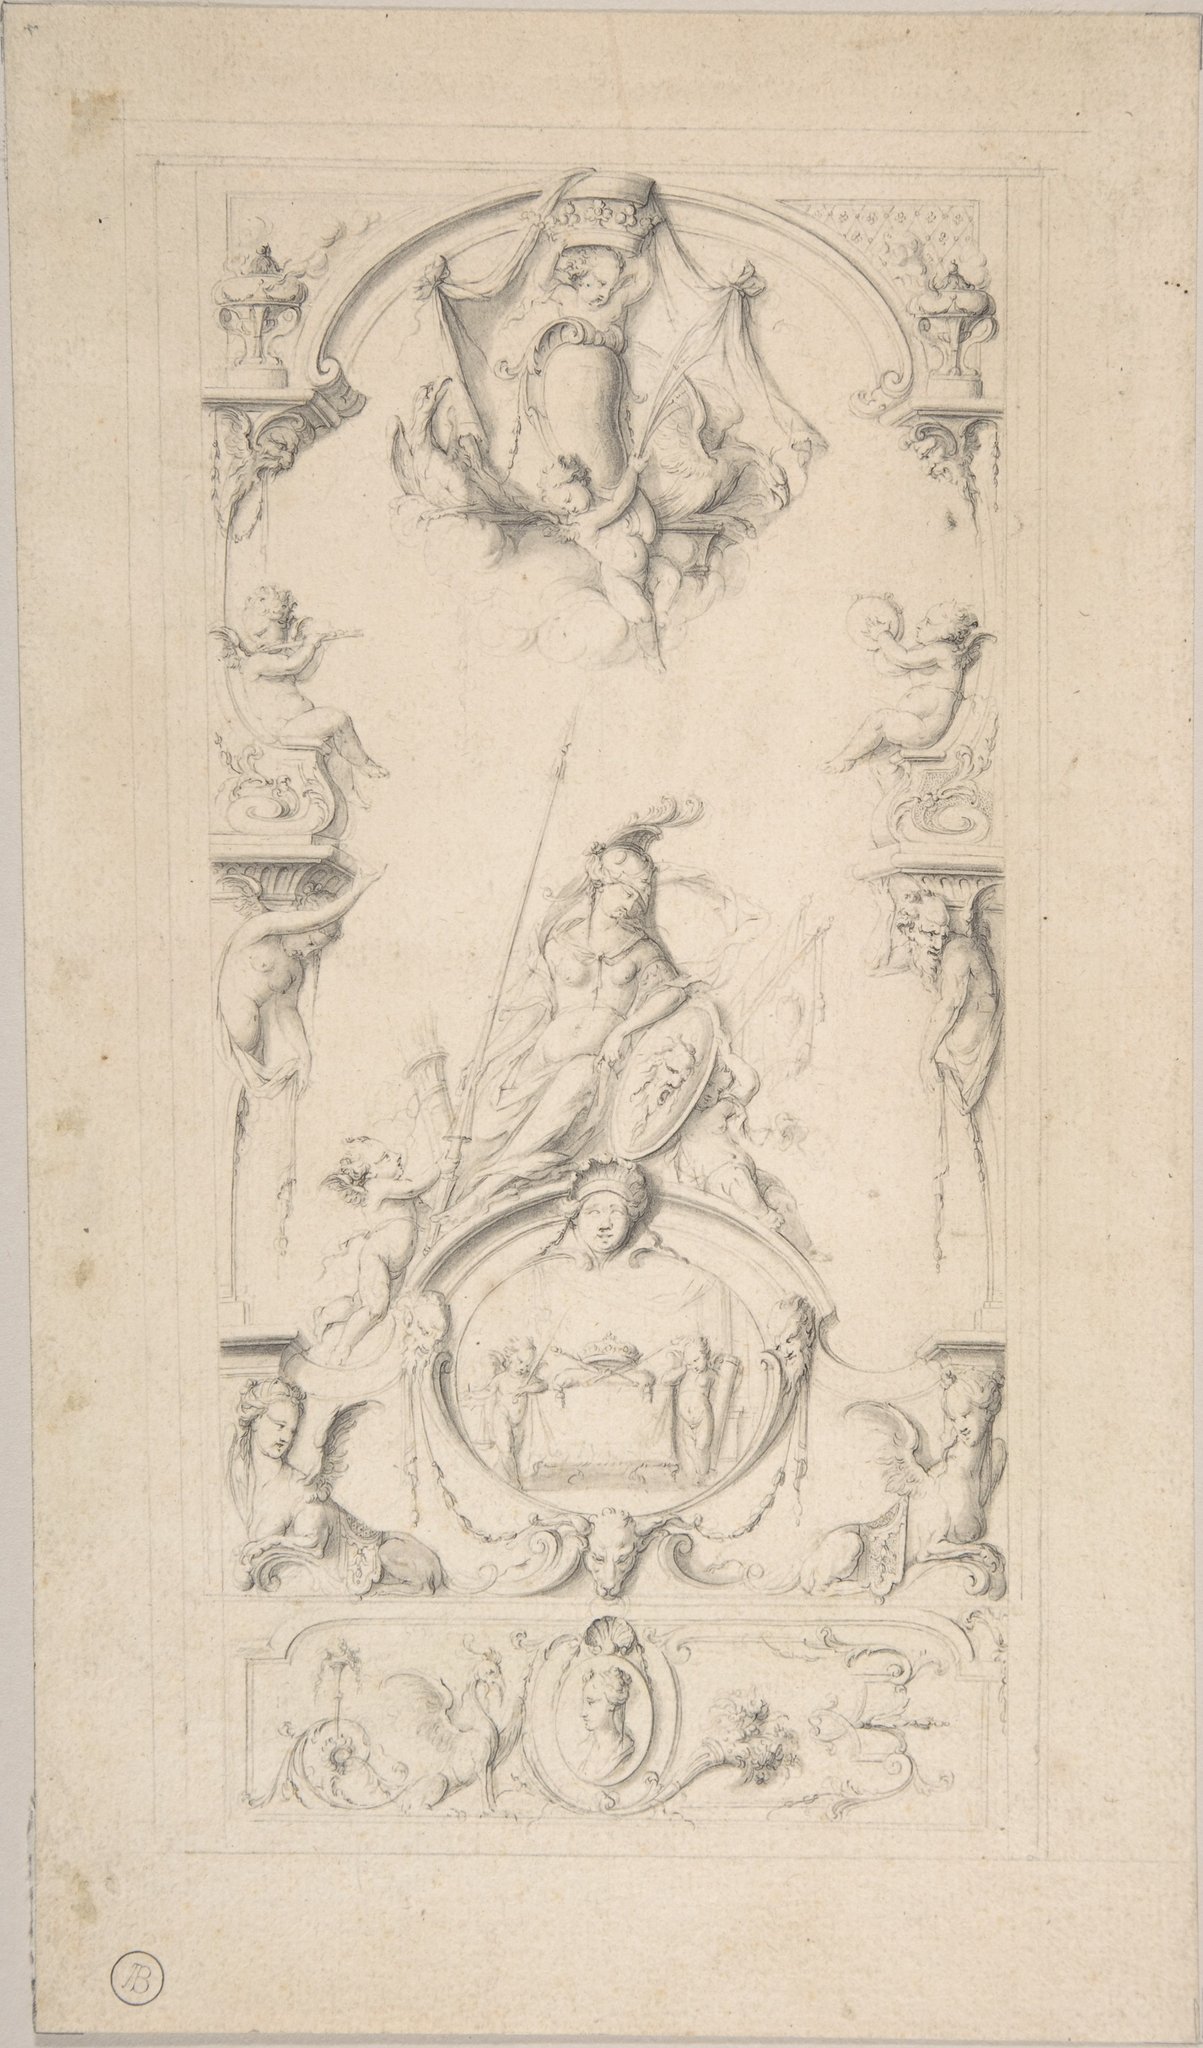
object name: drawing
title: Study for an Ornamental Panel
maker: jean bernard toro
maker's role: artist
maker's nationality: french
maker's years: 1672-1731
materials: chalk, ink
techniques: brush, pen, wash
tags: musical instruments,birds,profiles,women